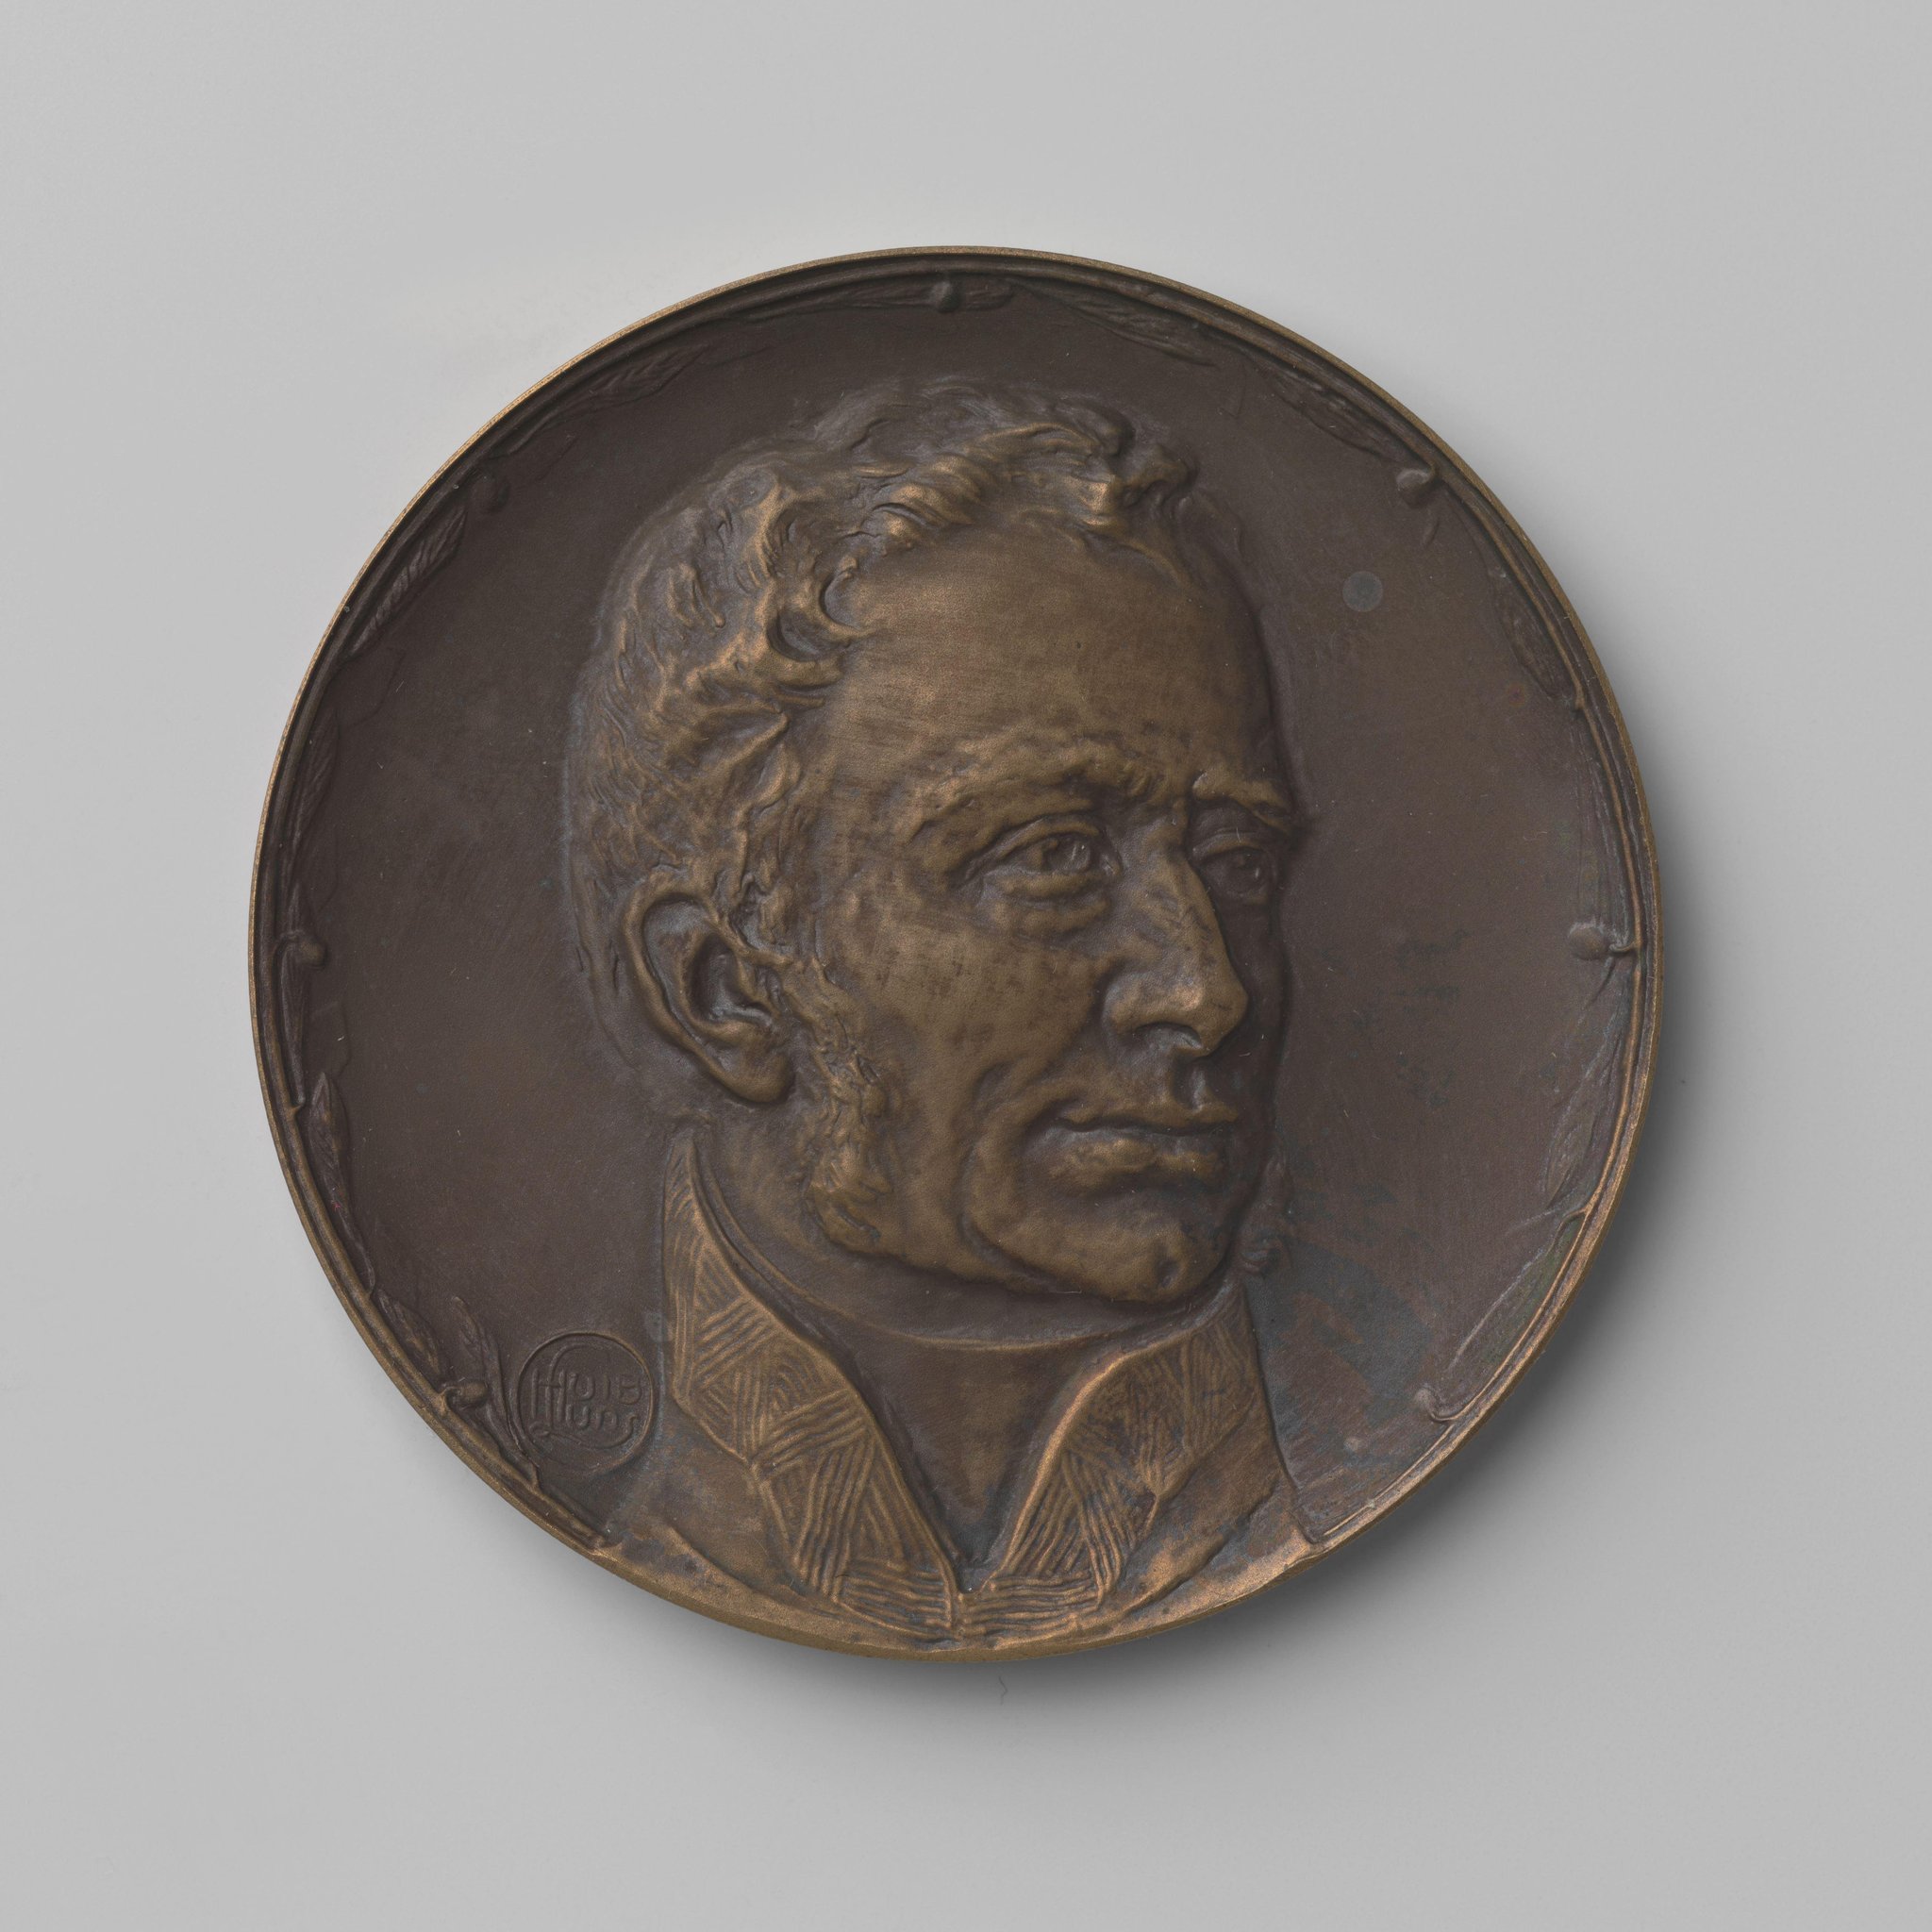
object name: history medal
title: Koning Willem I (Vereniging voor Penningkunst 1928, eerste penning)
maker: huib luns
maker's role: draughtsman, print maker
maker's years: 1881-1942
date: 1928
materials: bronze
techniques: striking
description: Bronzen penning, op de voorzijde het borstbeeld van Willem I half van rechts, op de keerzijde een tekstlint waarachter een mercuriusstaf met -hoed, een drietand met dolfijn en een hamer met een gevleugeld tandrad, met omschrift, met verklaring.